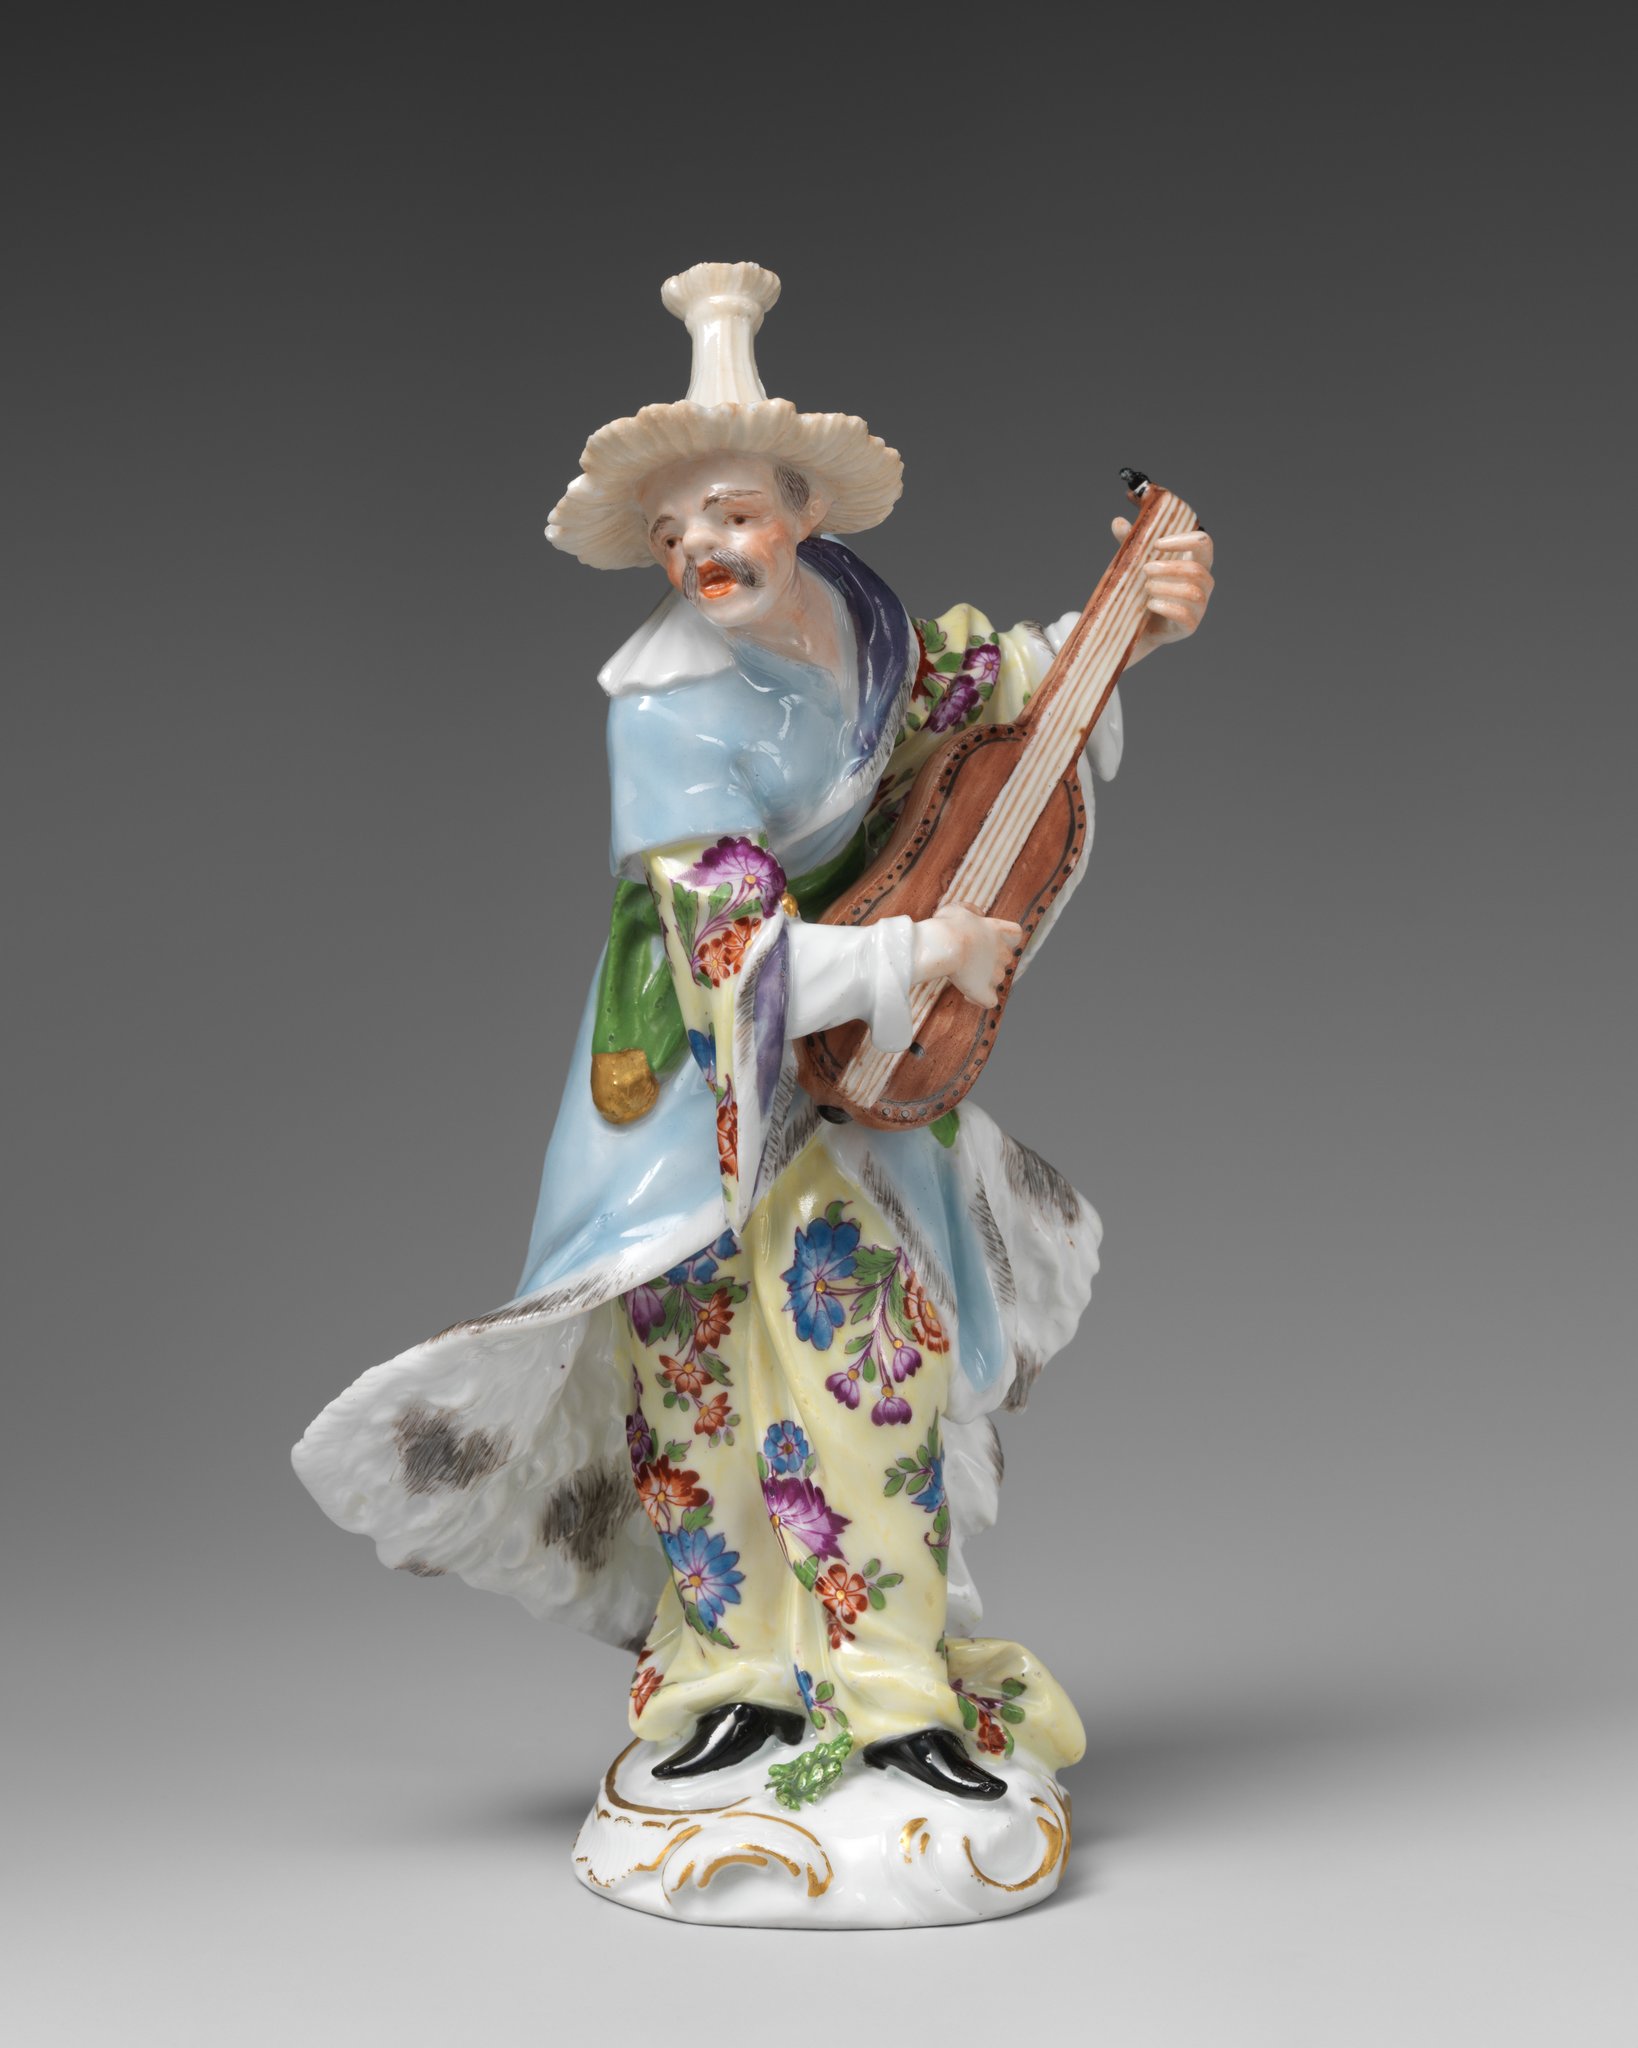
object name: figure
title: Chinese musician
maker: meissen manufactory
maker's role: manufactory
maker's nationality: german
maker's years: 1710-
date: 1763-1774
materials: hard paste porcelain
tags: musical instruments,men,musicians